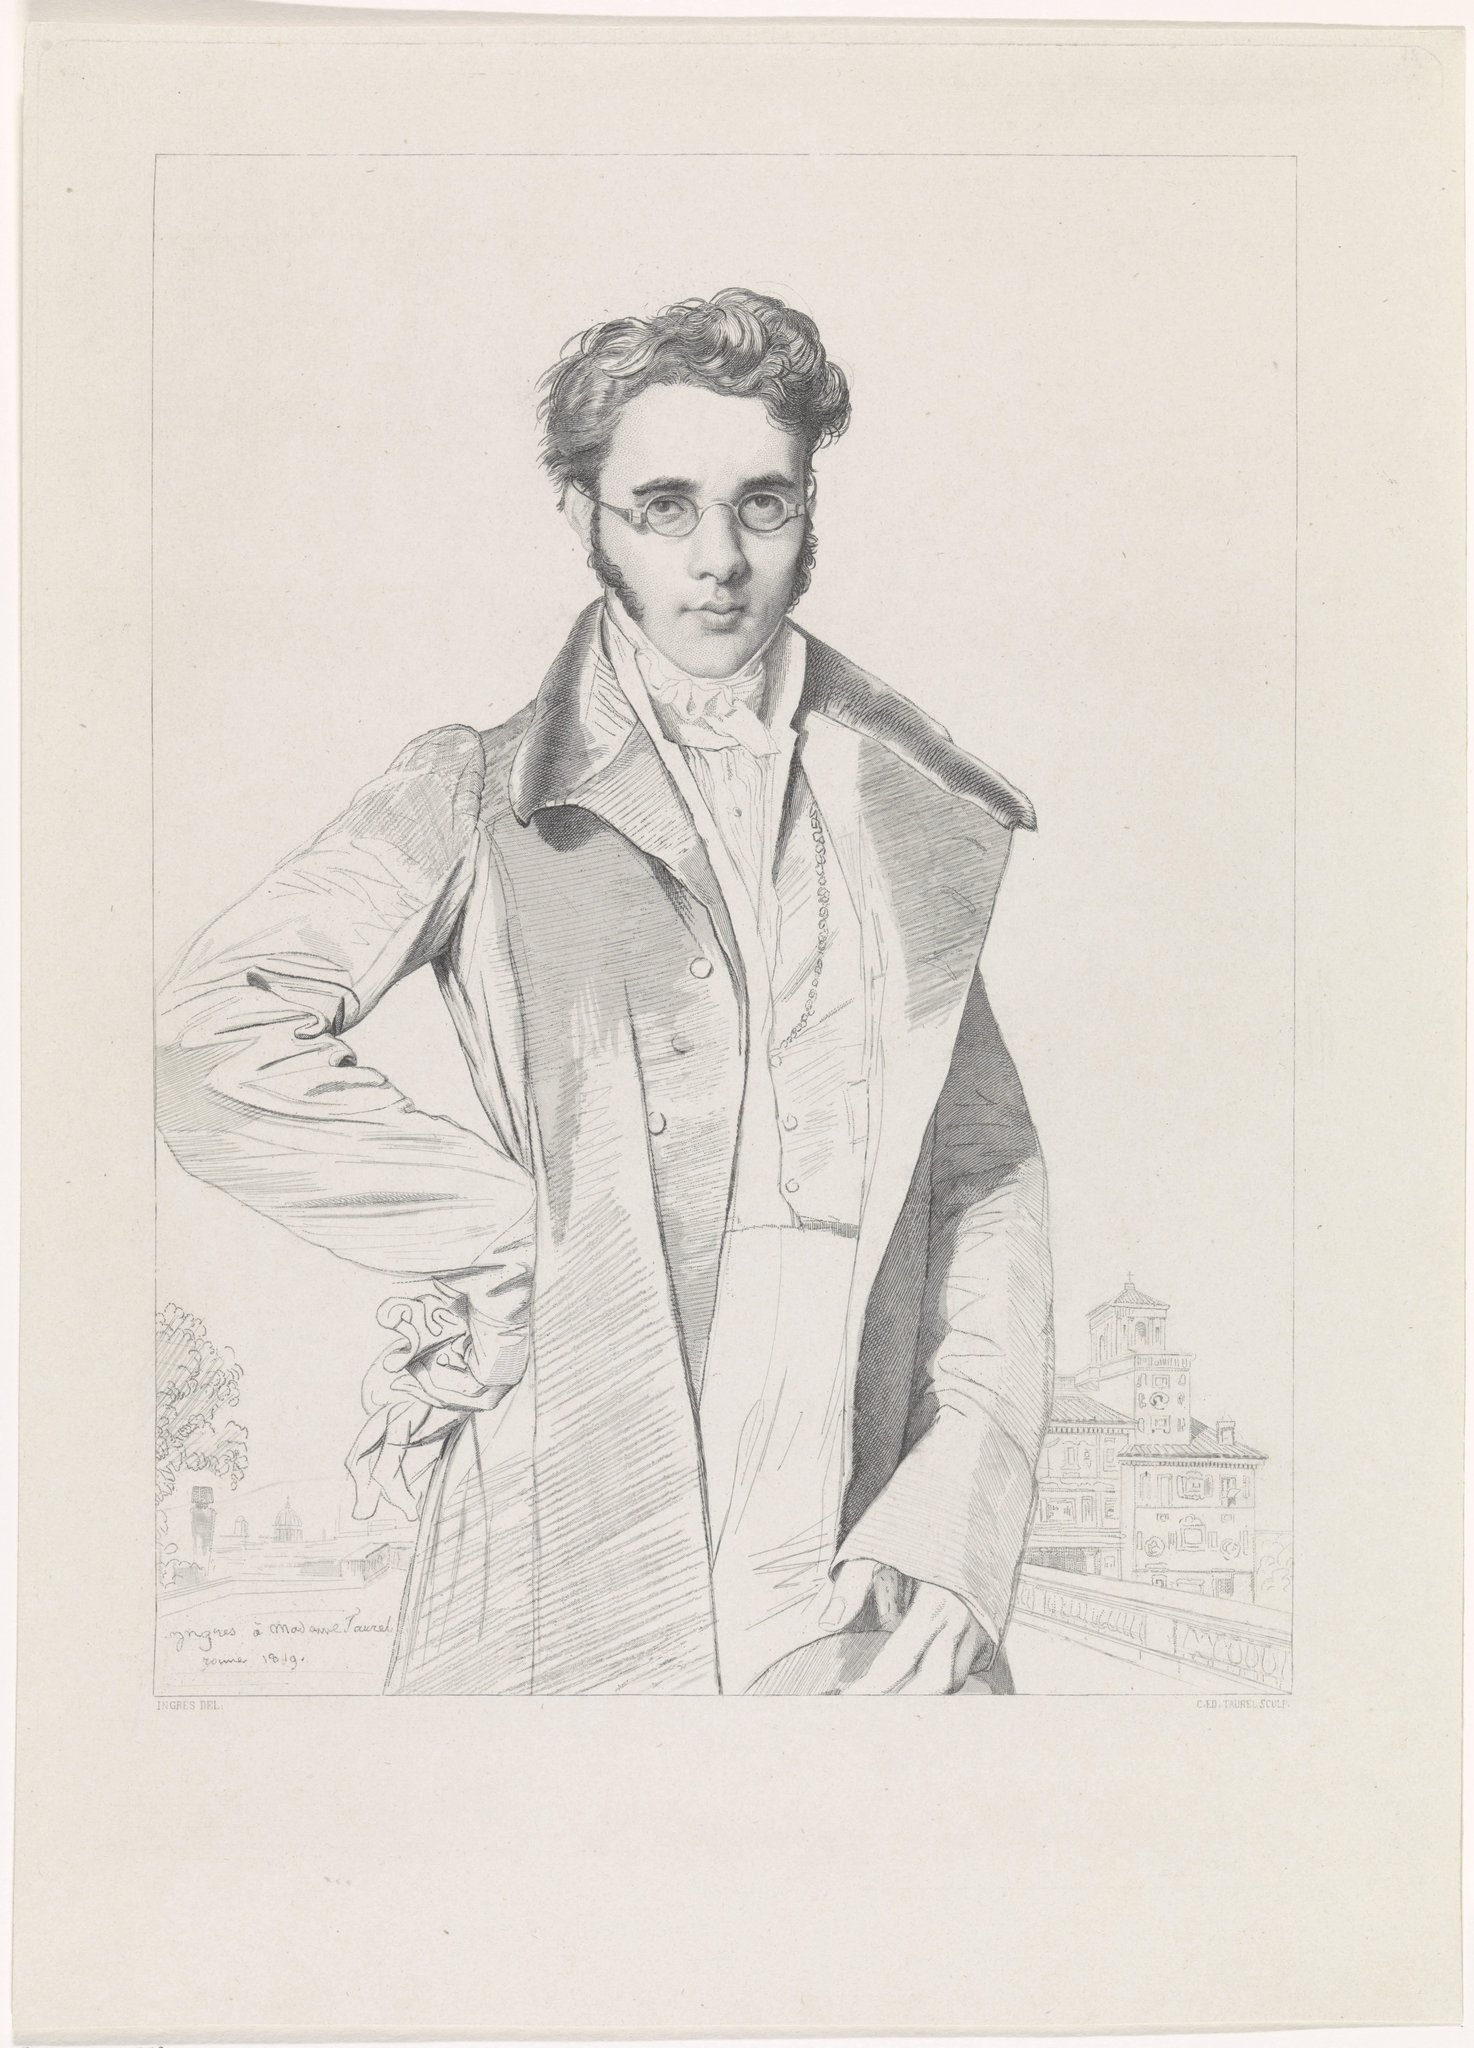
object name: print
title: Portret van Benoit Taurel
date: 1819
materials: paper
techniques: engraving, etching, roulette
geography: amsterdam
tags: paris, amsterdam, print maker, draughtsman, benoit taurel, eyeglasses, spectacles, youth, adolescent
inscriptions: collector's mark: Lugt 2228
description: Prent ook gebruikt als illustratie in: L'album T. douze eaux-fortes d'après des dessins originaux et inédits de Jean Alaux, Léon Cogniet, Coutan, Henriquel Dupont, Ingres, Léopold Robert et Etna Michalon avec texte explicatif et biographique enrichi de lettres inédites. Amsterdam en Den Haag: 1885.